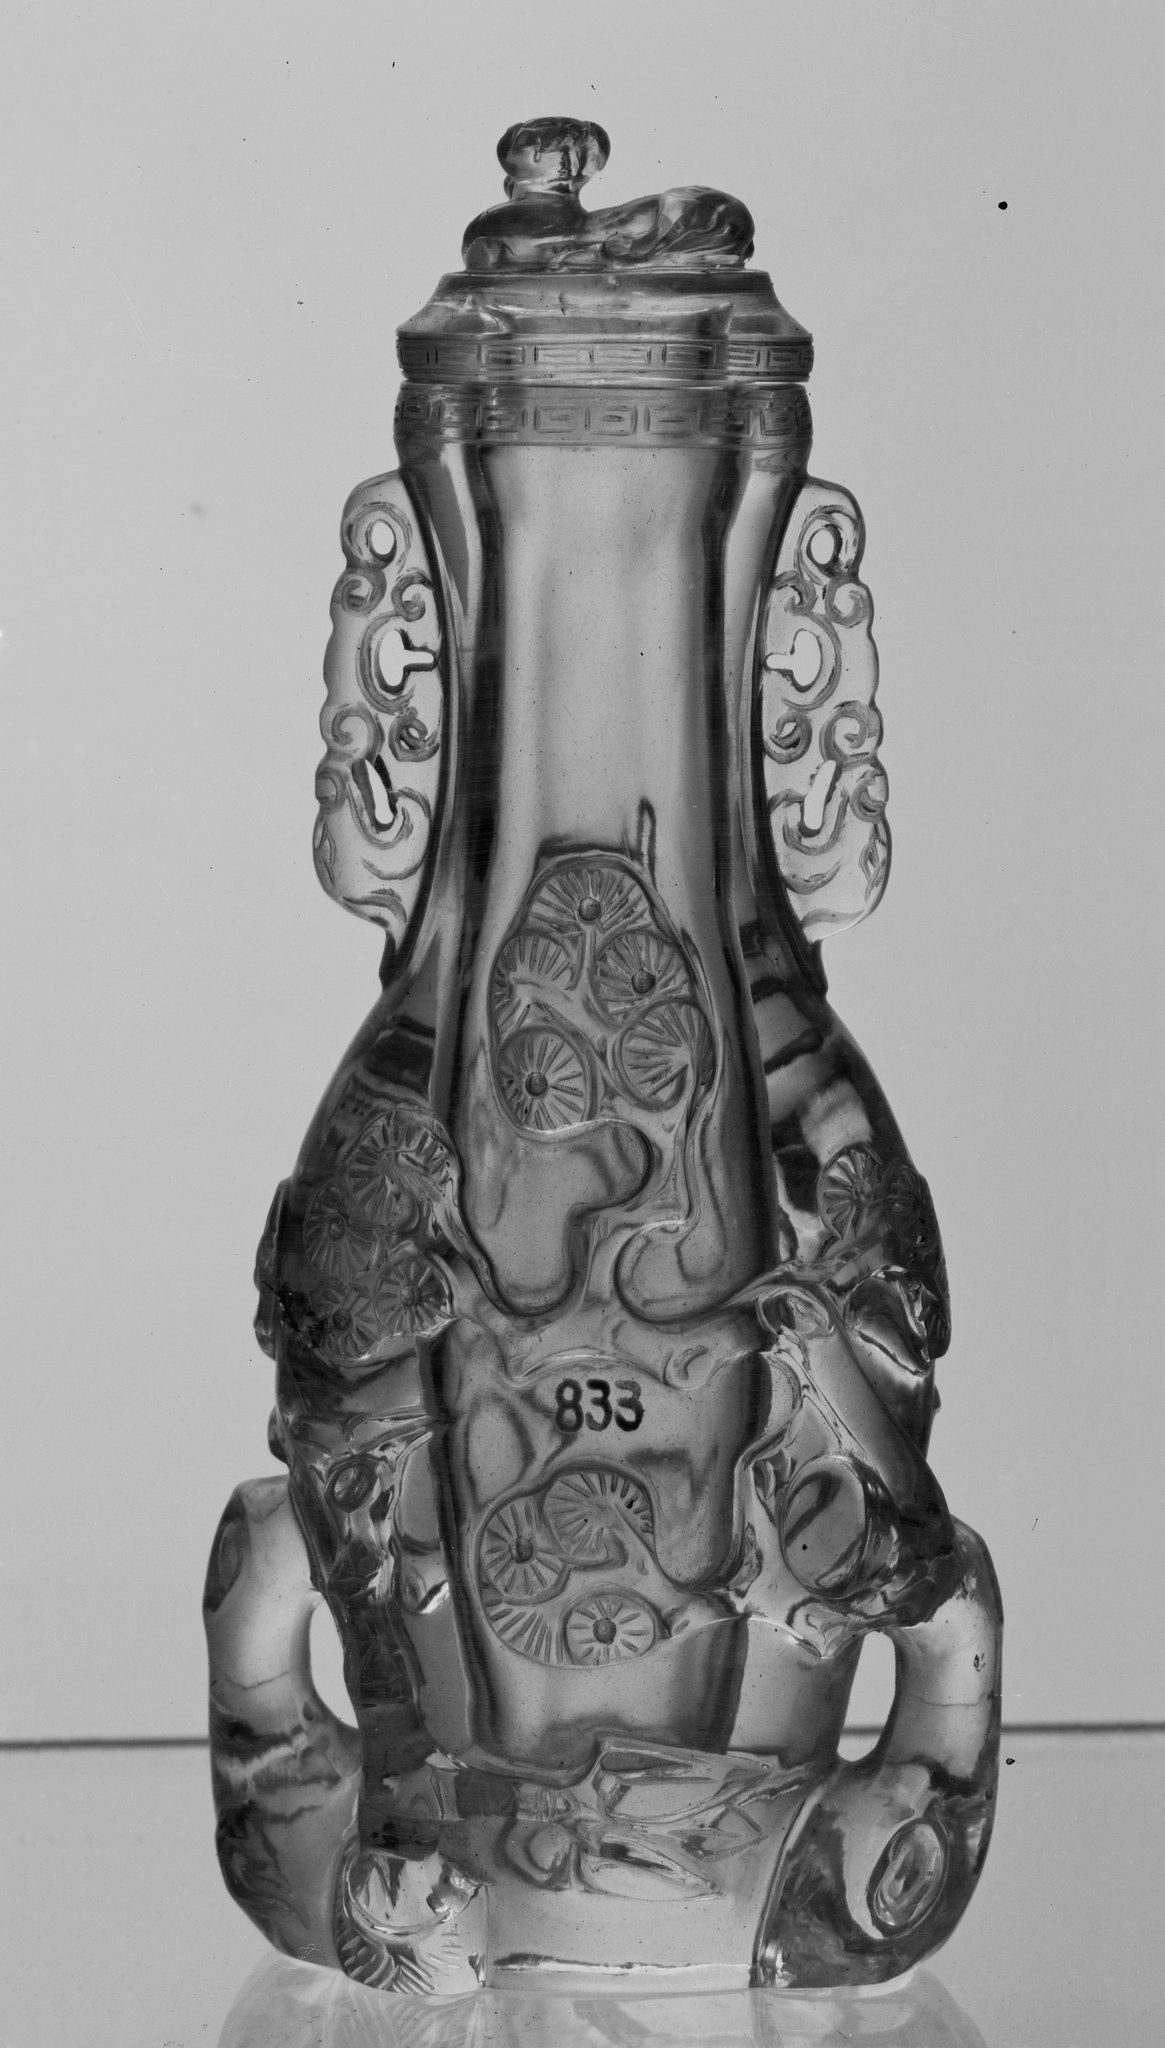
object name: vase with cover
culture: chinese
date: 1701-1900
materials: quartz